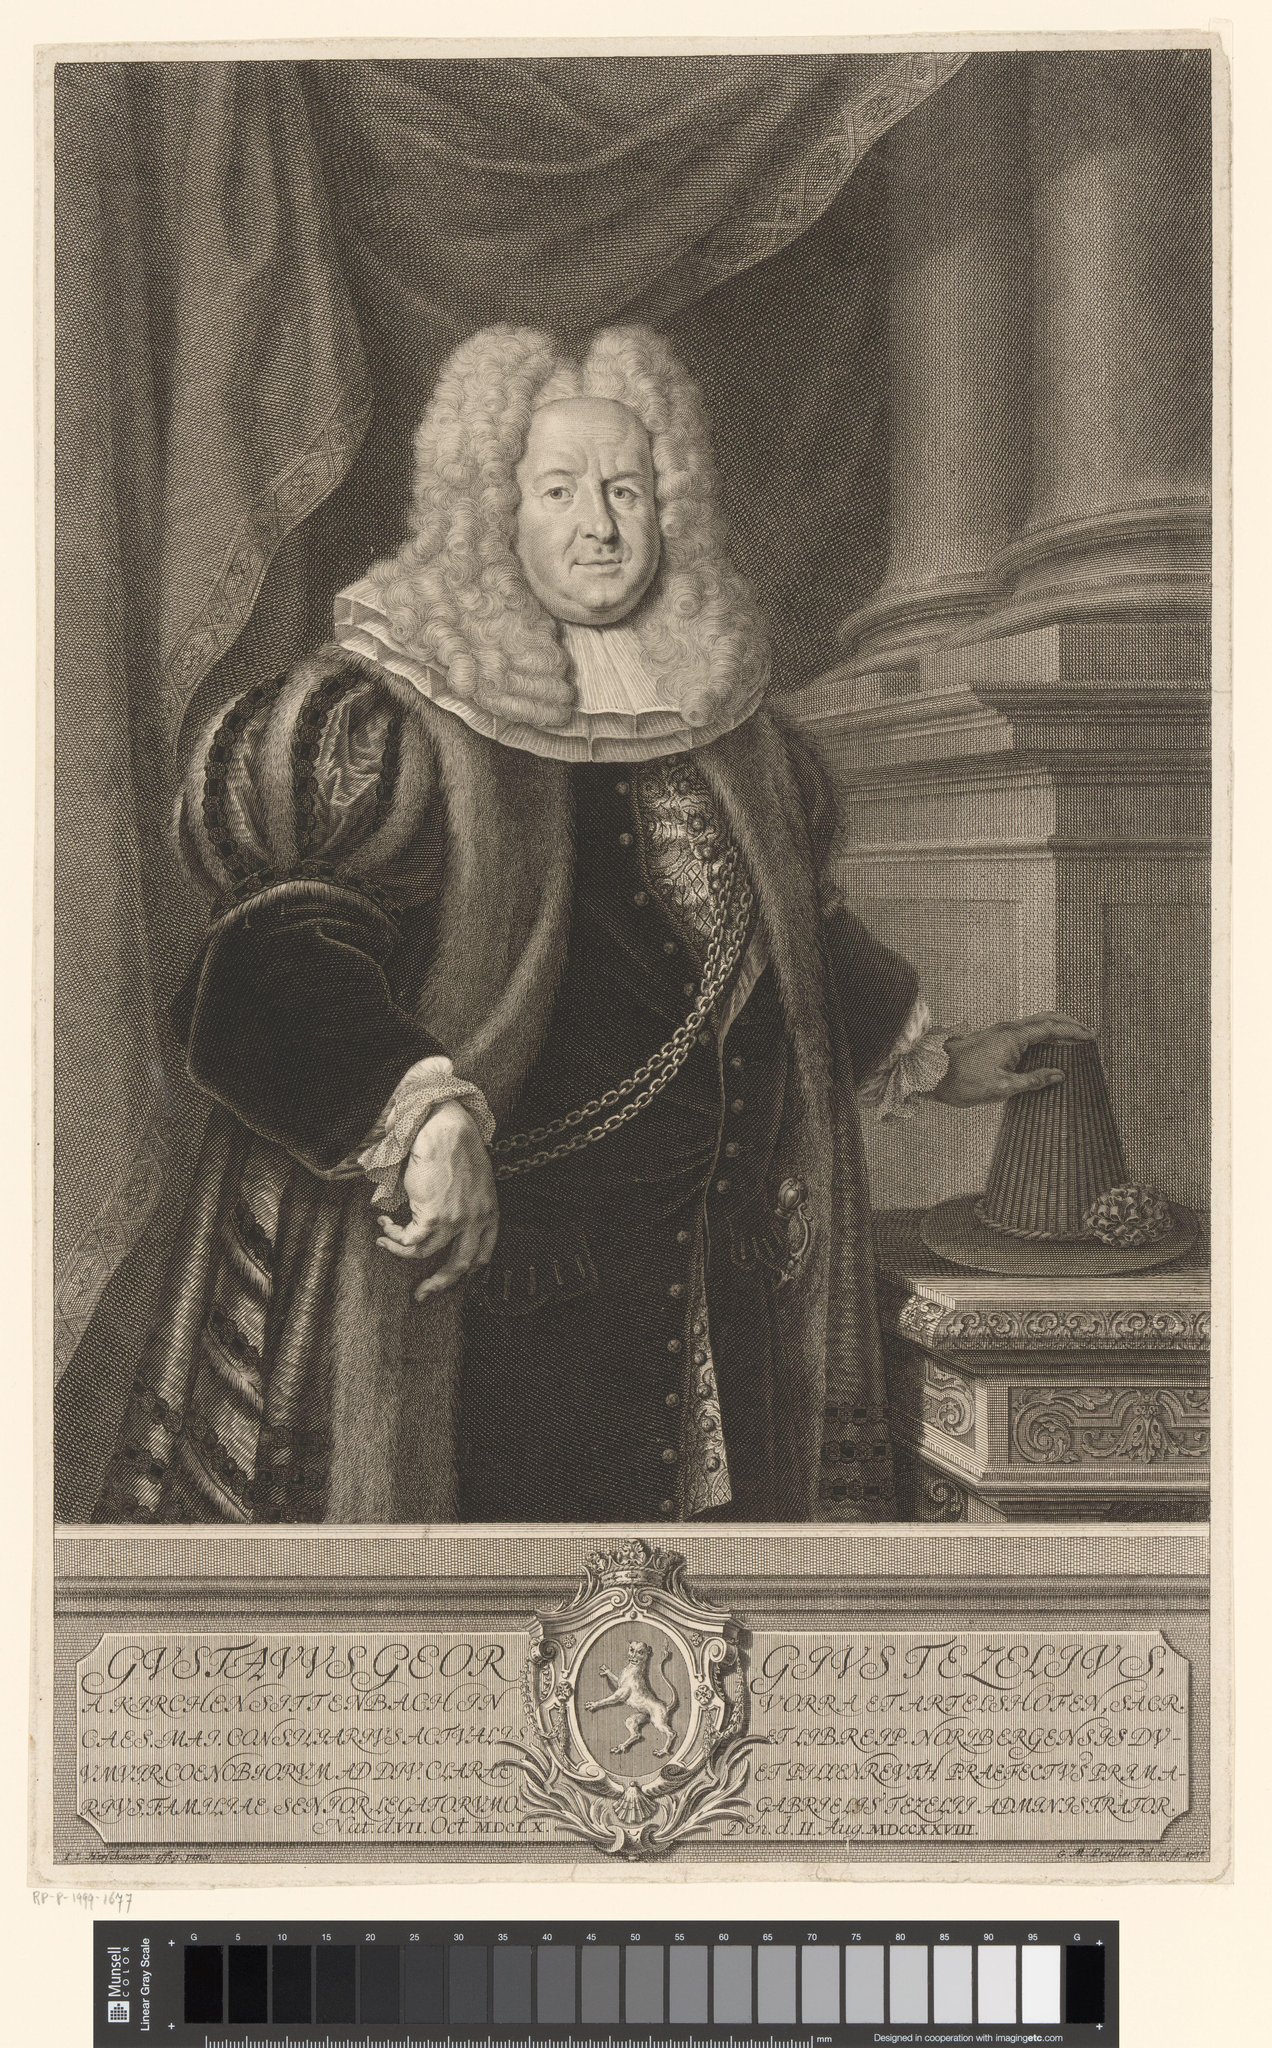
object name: print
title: Portret van Gustav Georg Tetzel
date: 1733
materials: paper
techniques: engraving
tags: mayor, historical persons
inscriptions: collector's mark: Lugt 2228